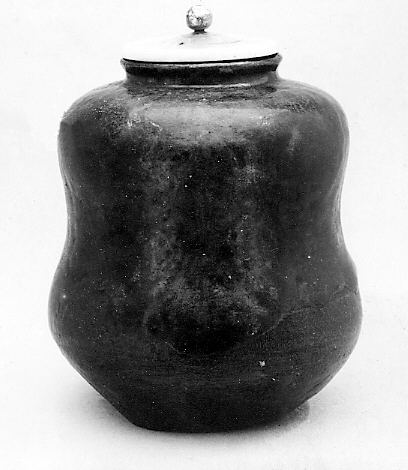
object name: tea jar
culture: japanese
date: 1701-1800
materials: clay, glaze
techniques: overglaze